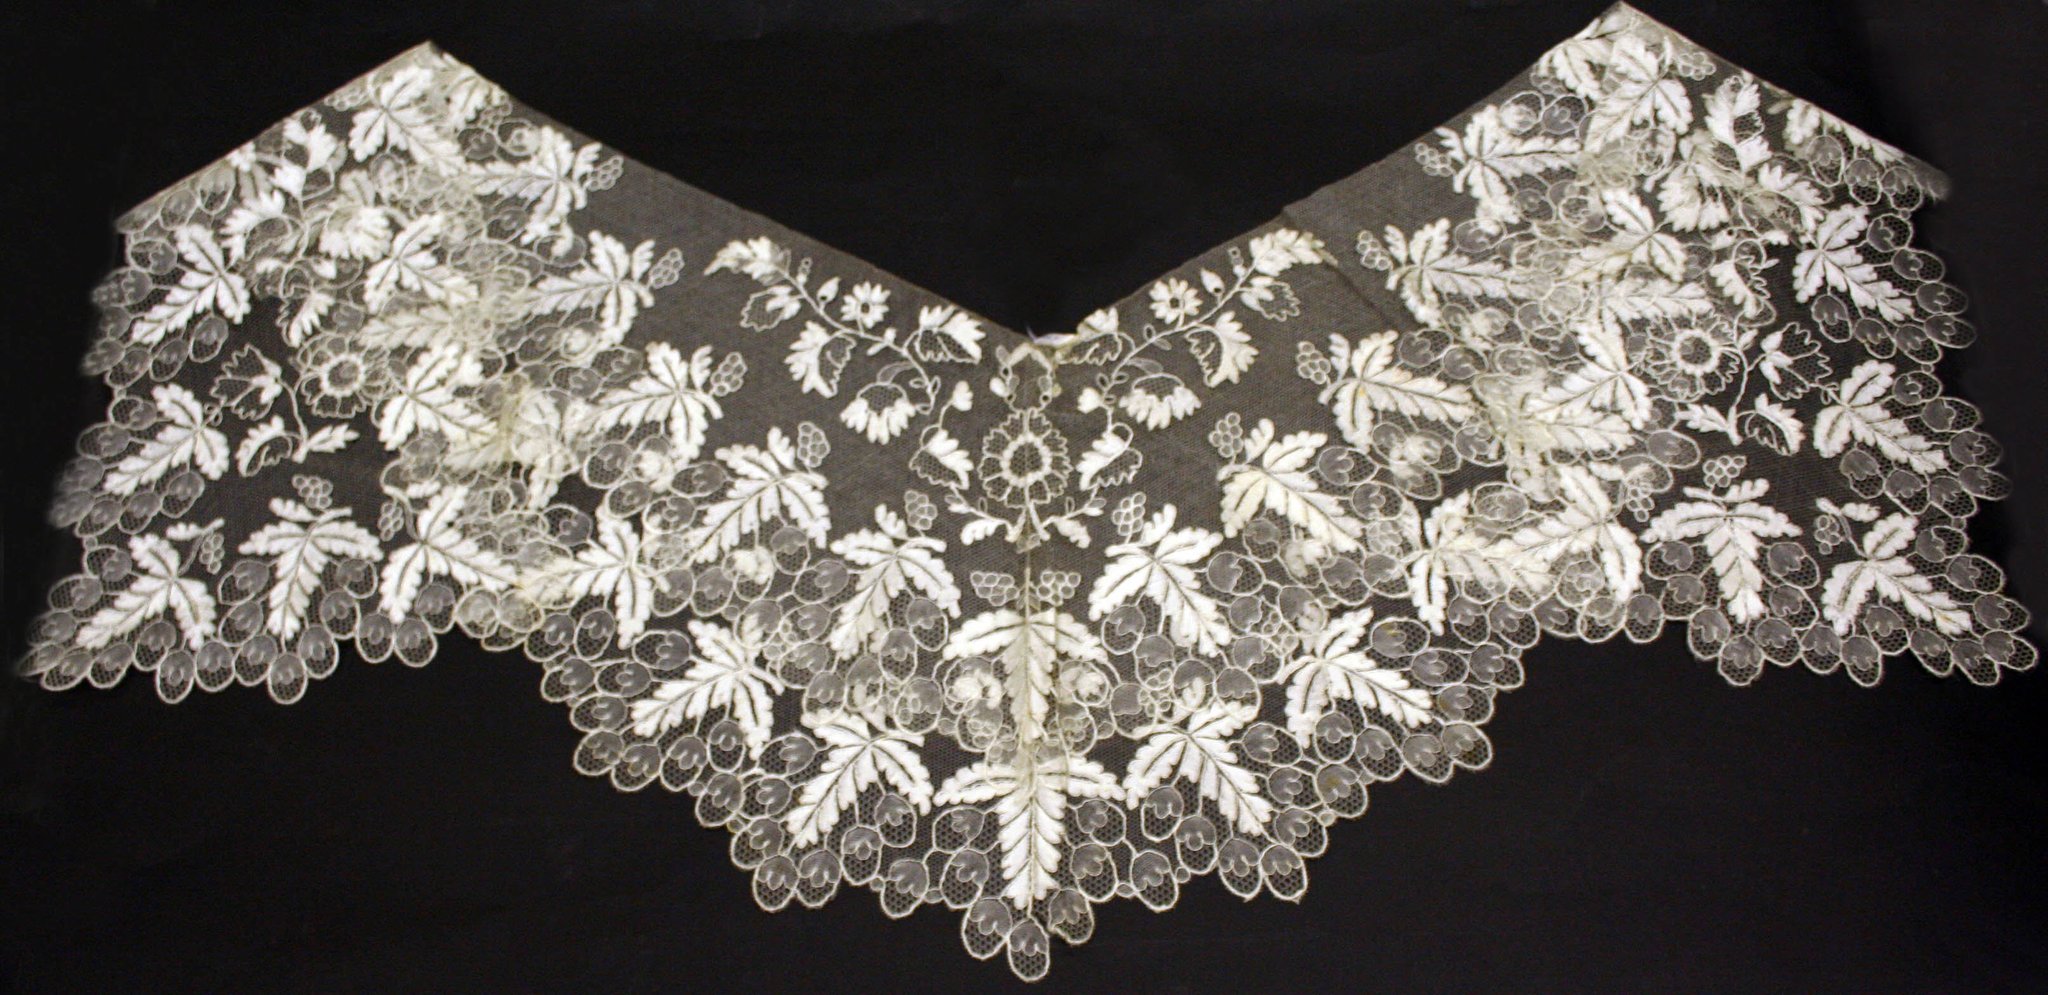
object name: pelerine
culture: french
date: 1830-1835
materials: cotton